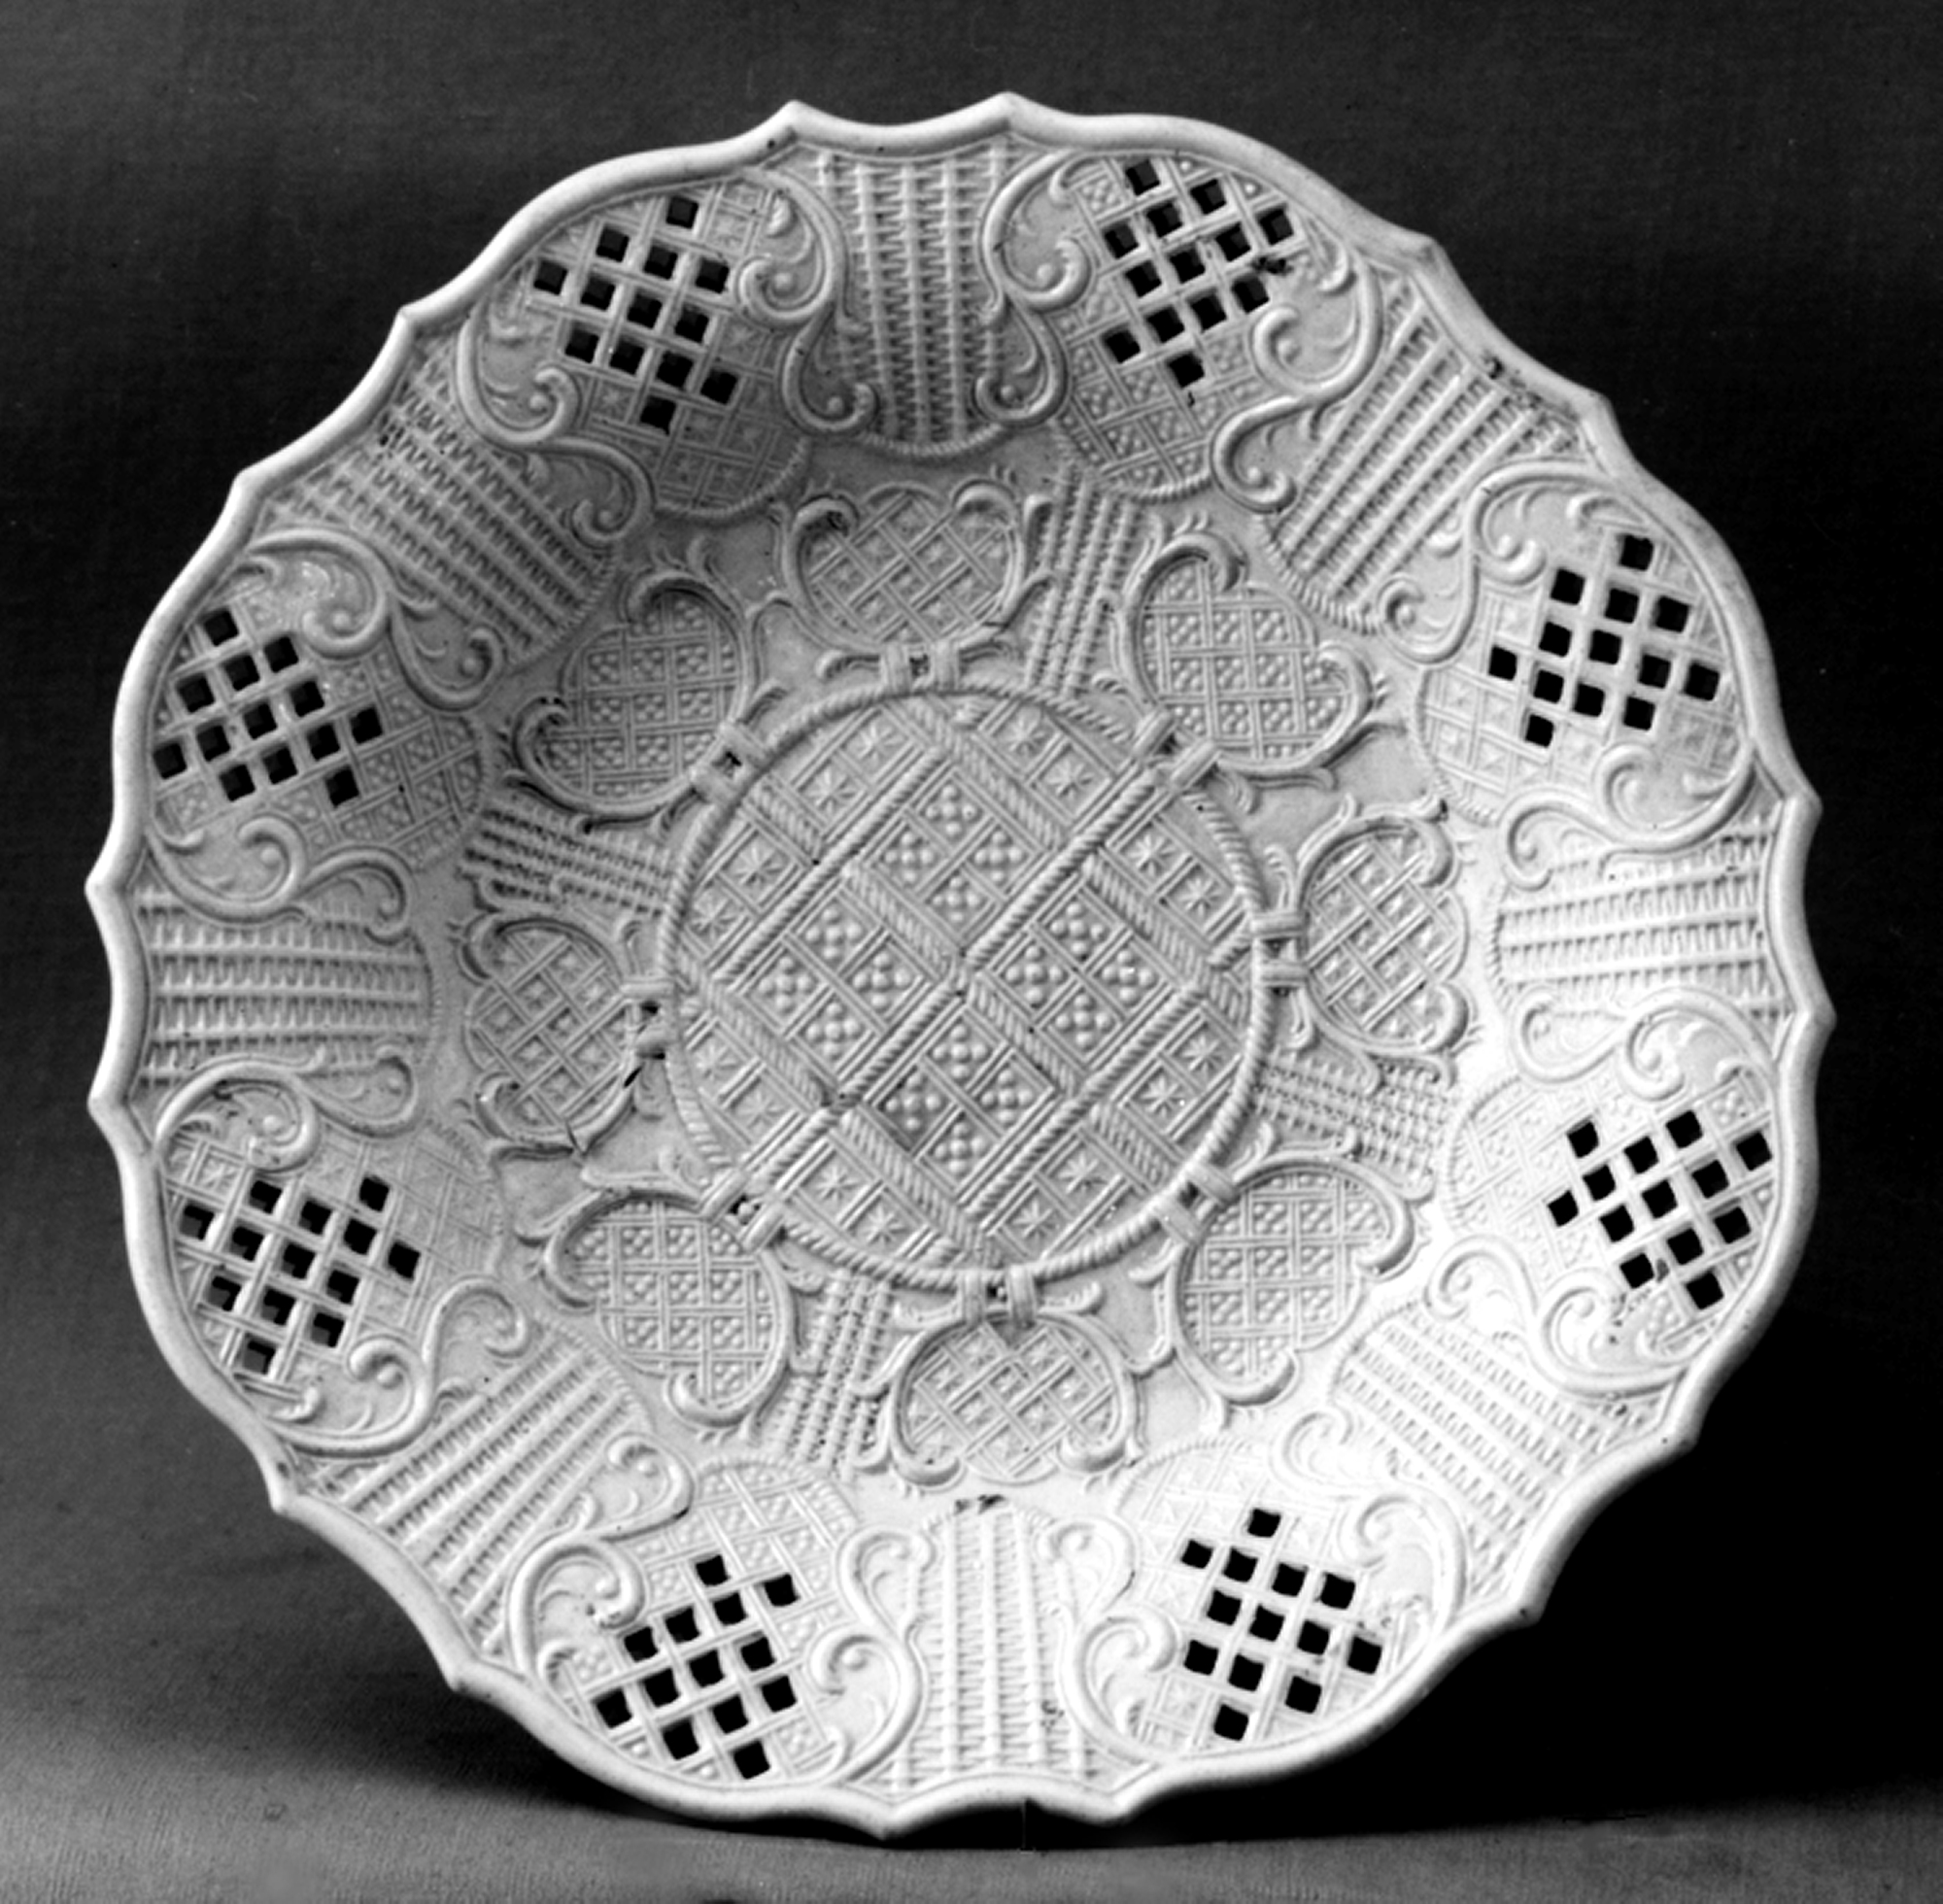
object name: dish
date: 1760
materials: stoneware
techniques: salt glaze